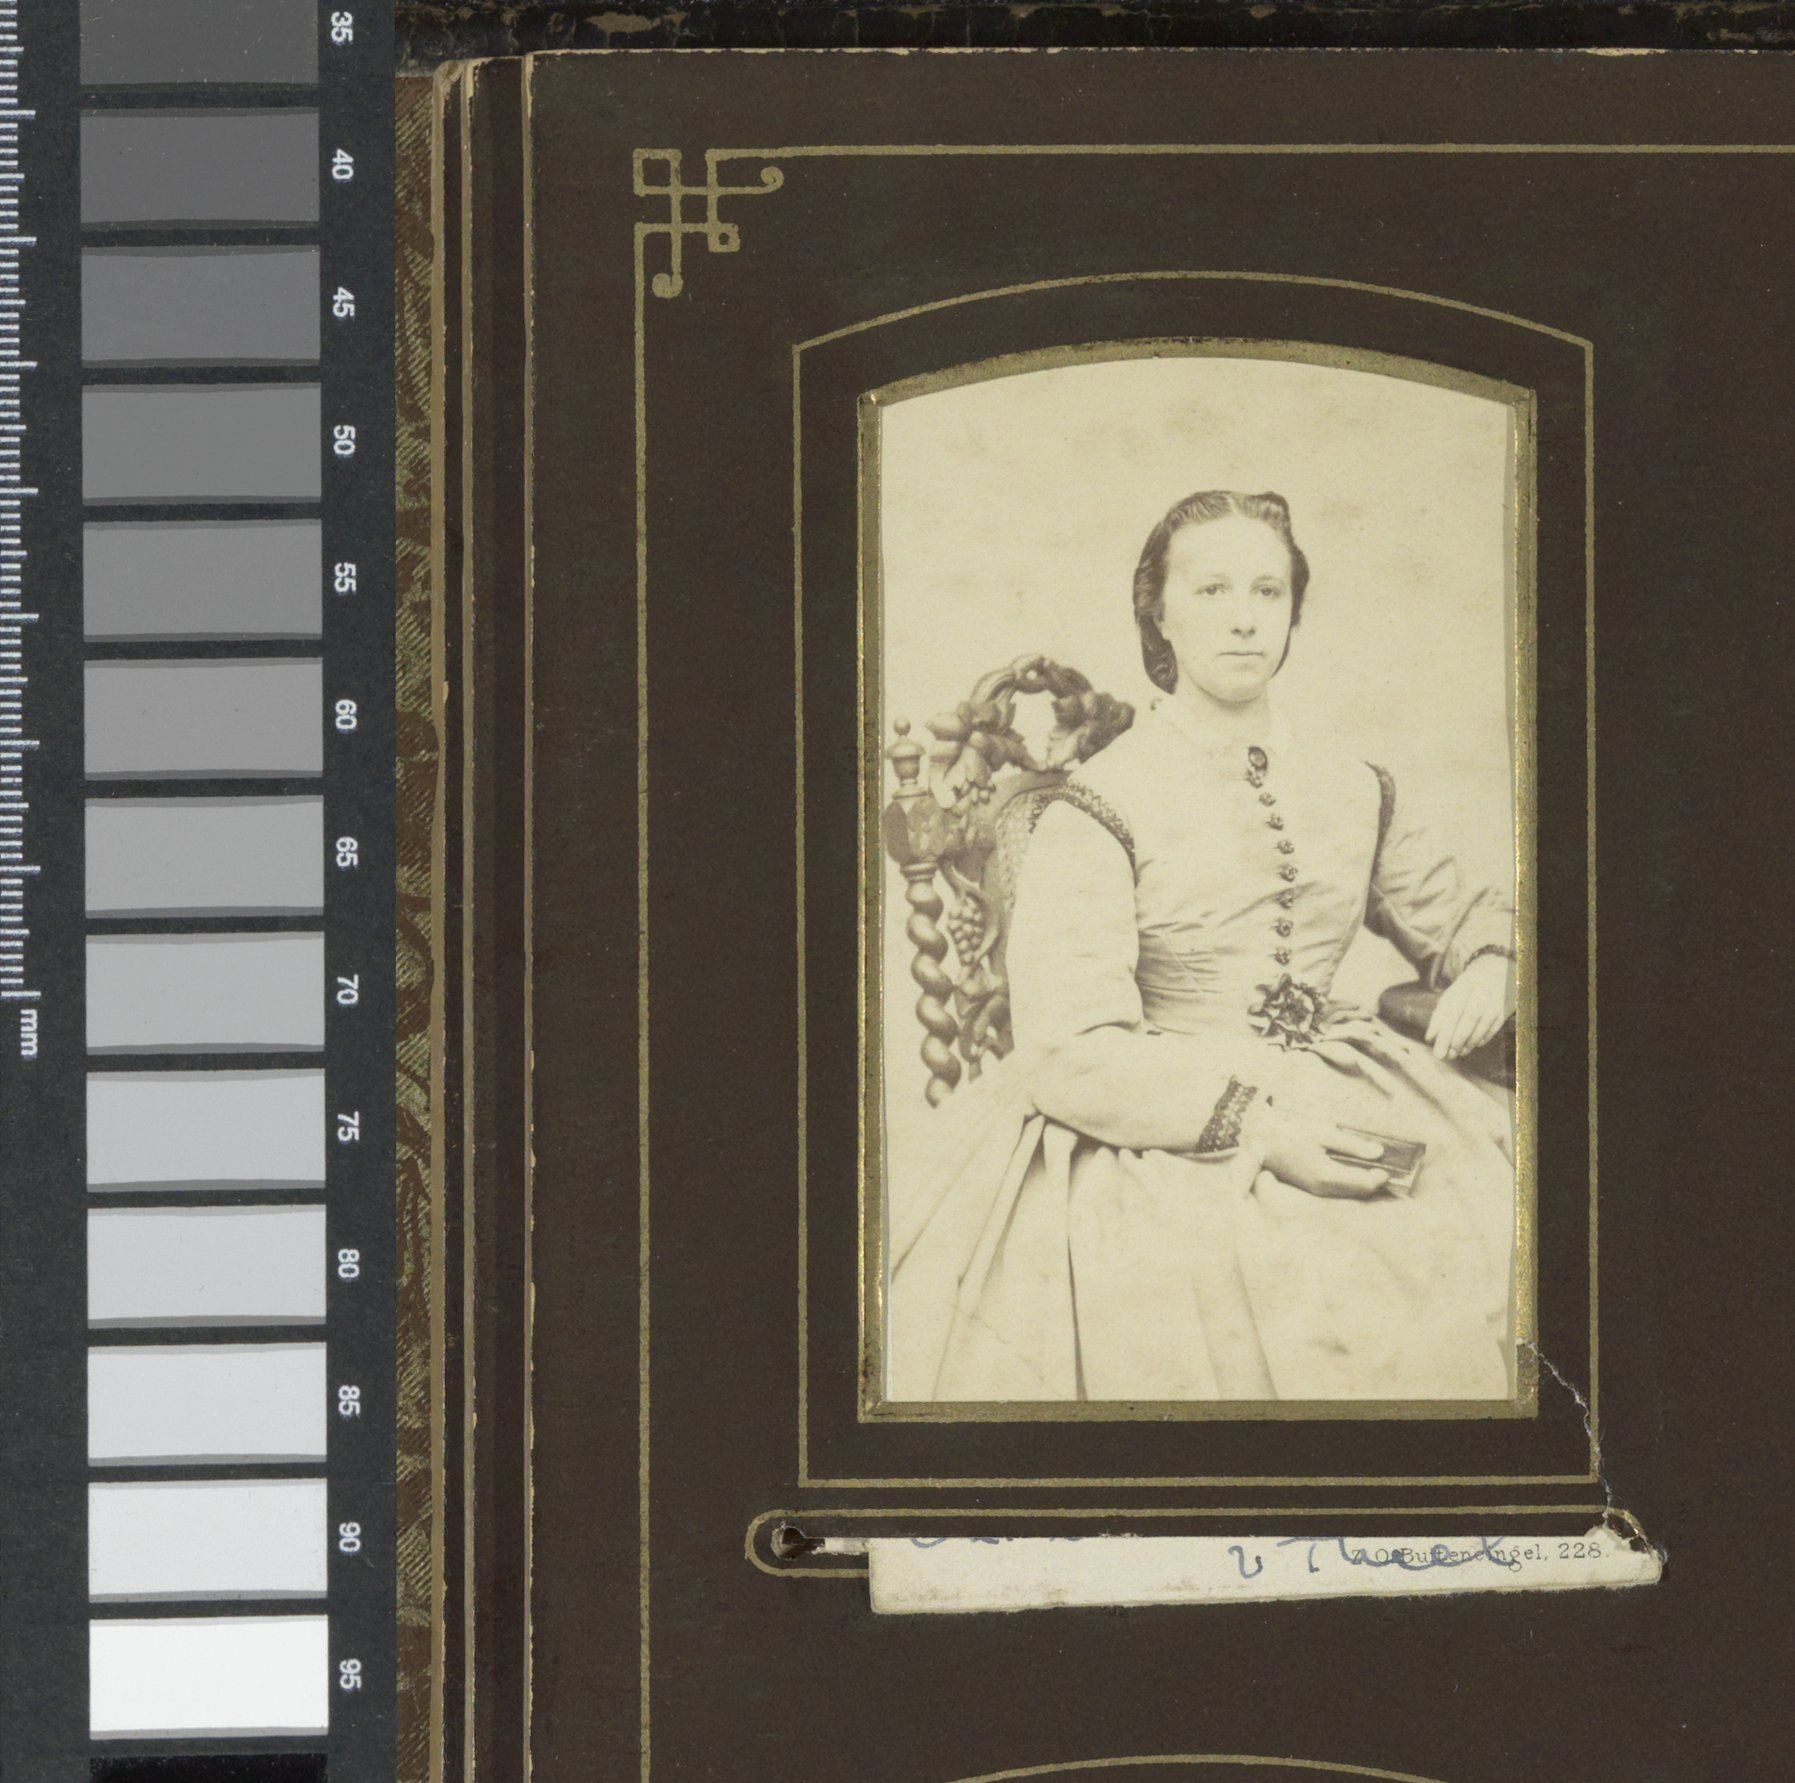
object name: album leaf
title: Portret van Ch. Doorman-Van Thiel, zittend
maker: jan rudolf frederik nievergeld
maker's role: docent, fotograaf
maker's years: 1826-1898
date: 1859-1879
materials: cardboard, paper, photographic support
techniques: albumen print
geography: the hague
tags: adult woman, historical persons - bb - woman, dress, gown, the hague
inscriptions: address: ‘'s Hage, Z.O. Buitensingel, 228.’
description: Onderdeel van Fotoalbum van de families Matthes, Doorman en Van Thiel.